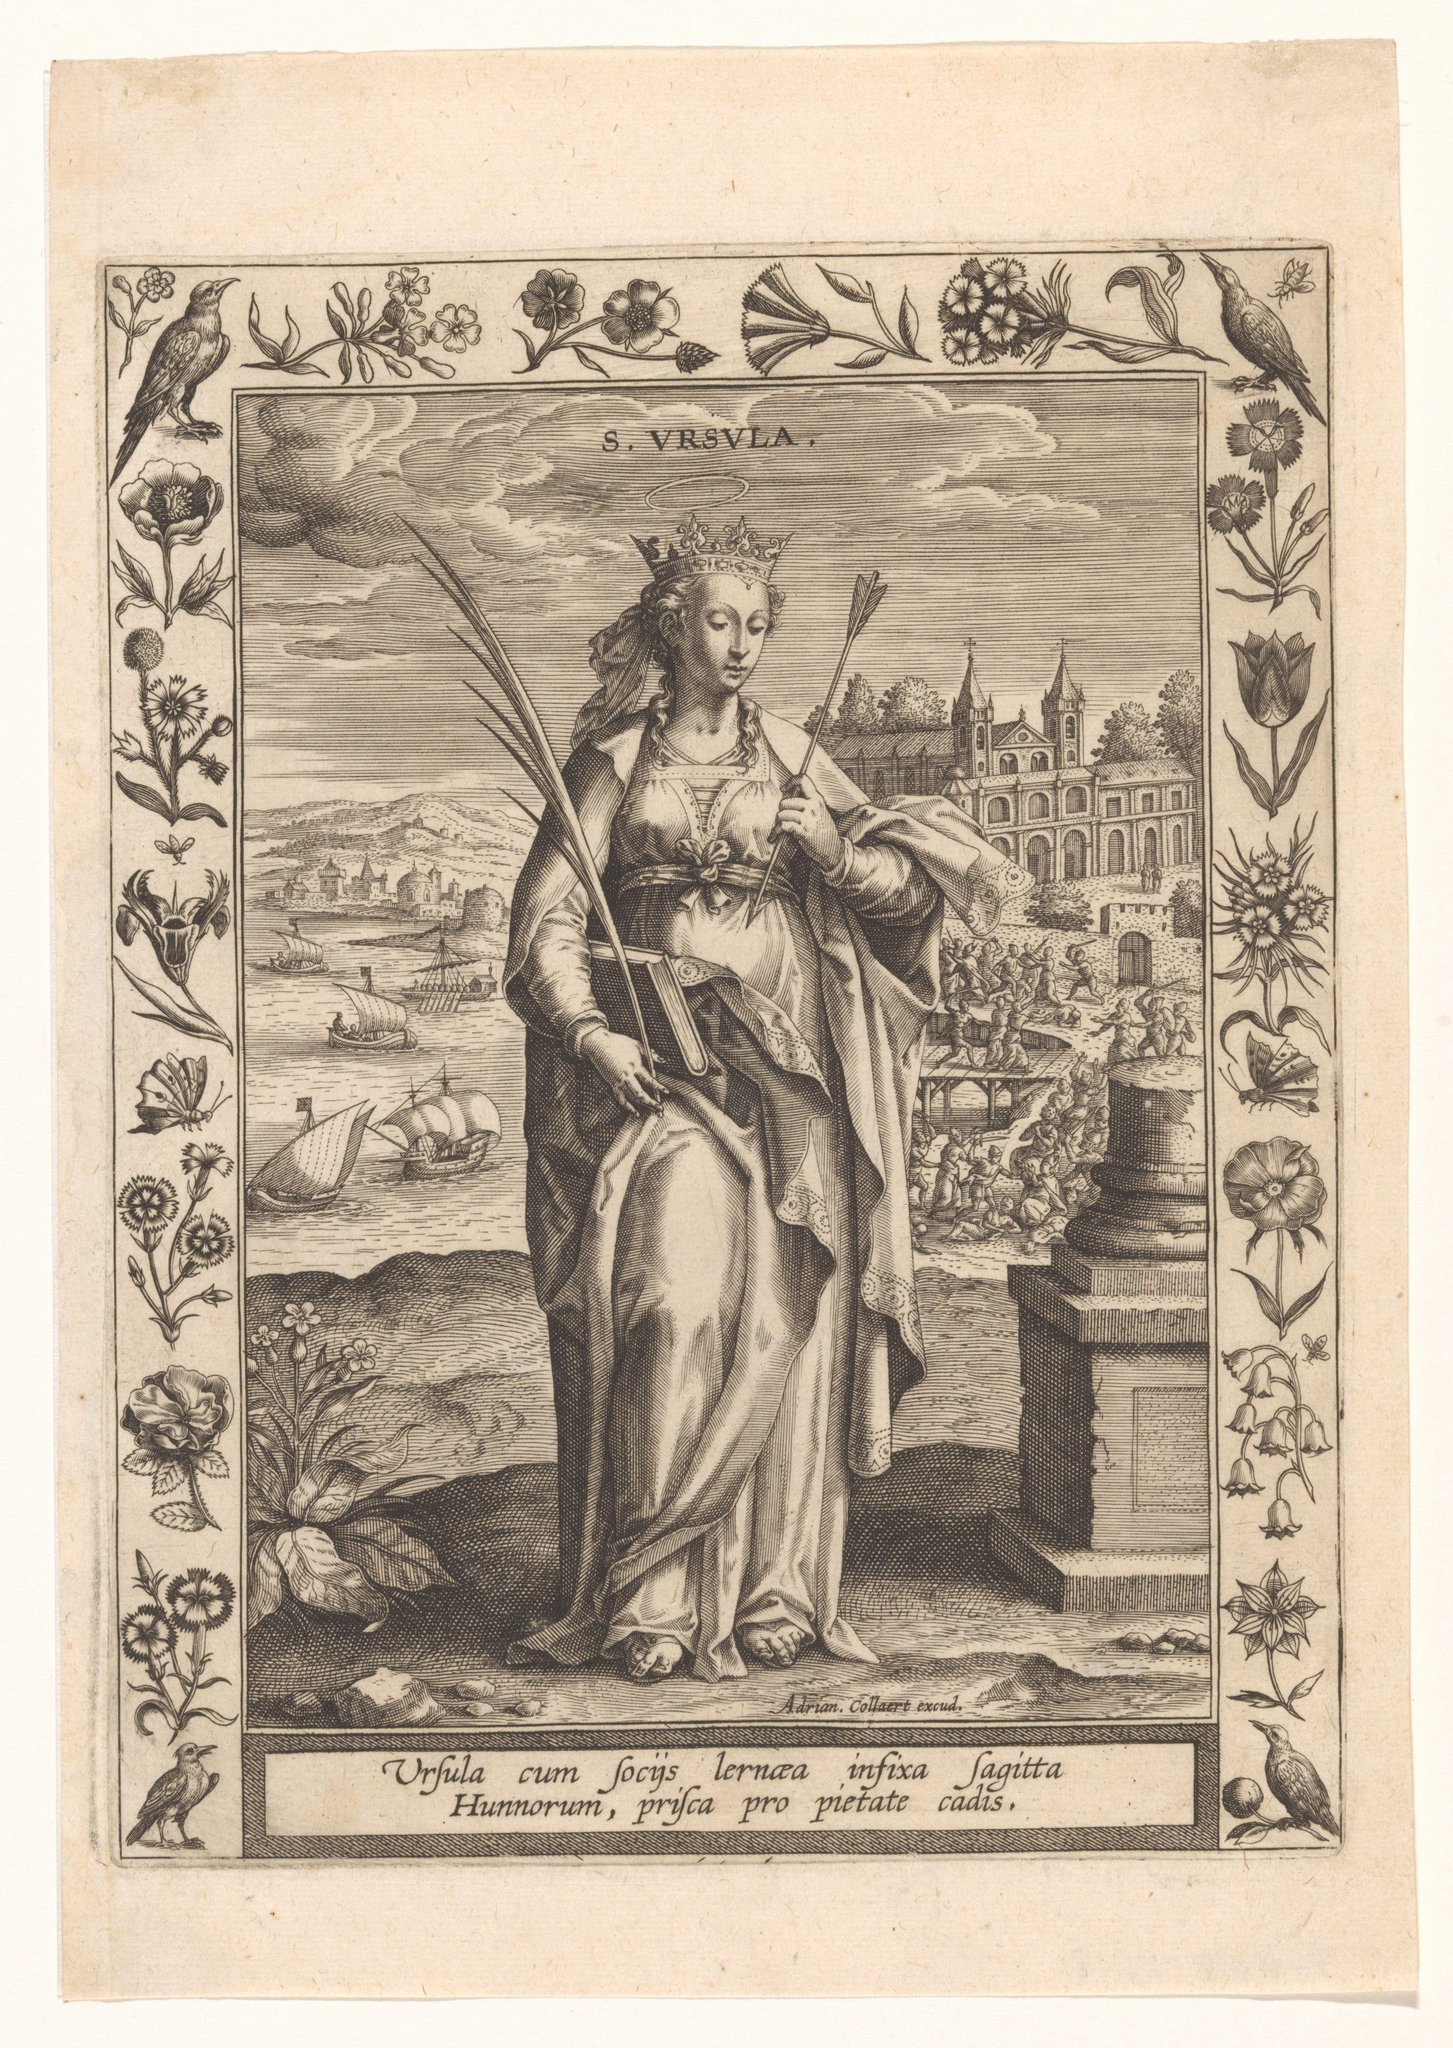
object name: print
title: Heilige Ursula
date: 1590-1610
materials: paper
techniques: engraving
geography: antwerp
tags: the virgin martyr ursula of cologne; possible attributes: arrow, banner with red cross, cloak of ermine, crown, ship, flowers, birds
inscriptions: collector's mark: Lugt 2228, collector's mark: Lugt 2760, collector's mark: Lugt 3751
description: Heilige Ursula. Onderdeel van een serie van 24 voorstellingen van vrouwelijke martelaren (martyrologium). De voorstellingen zijn voorzien van randen met bloemen en dieren.